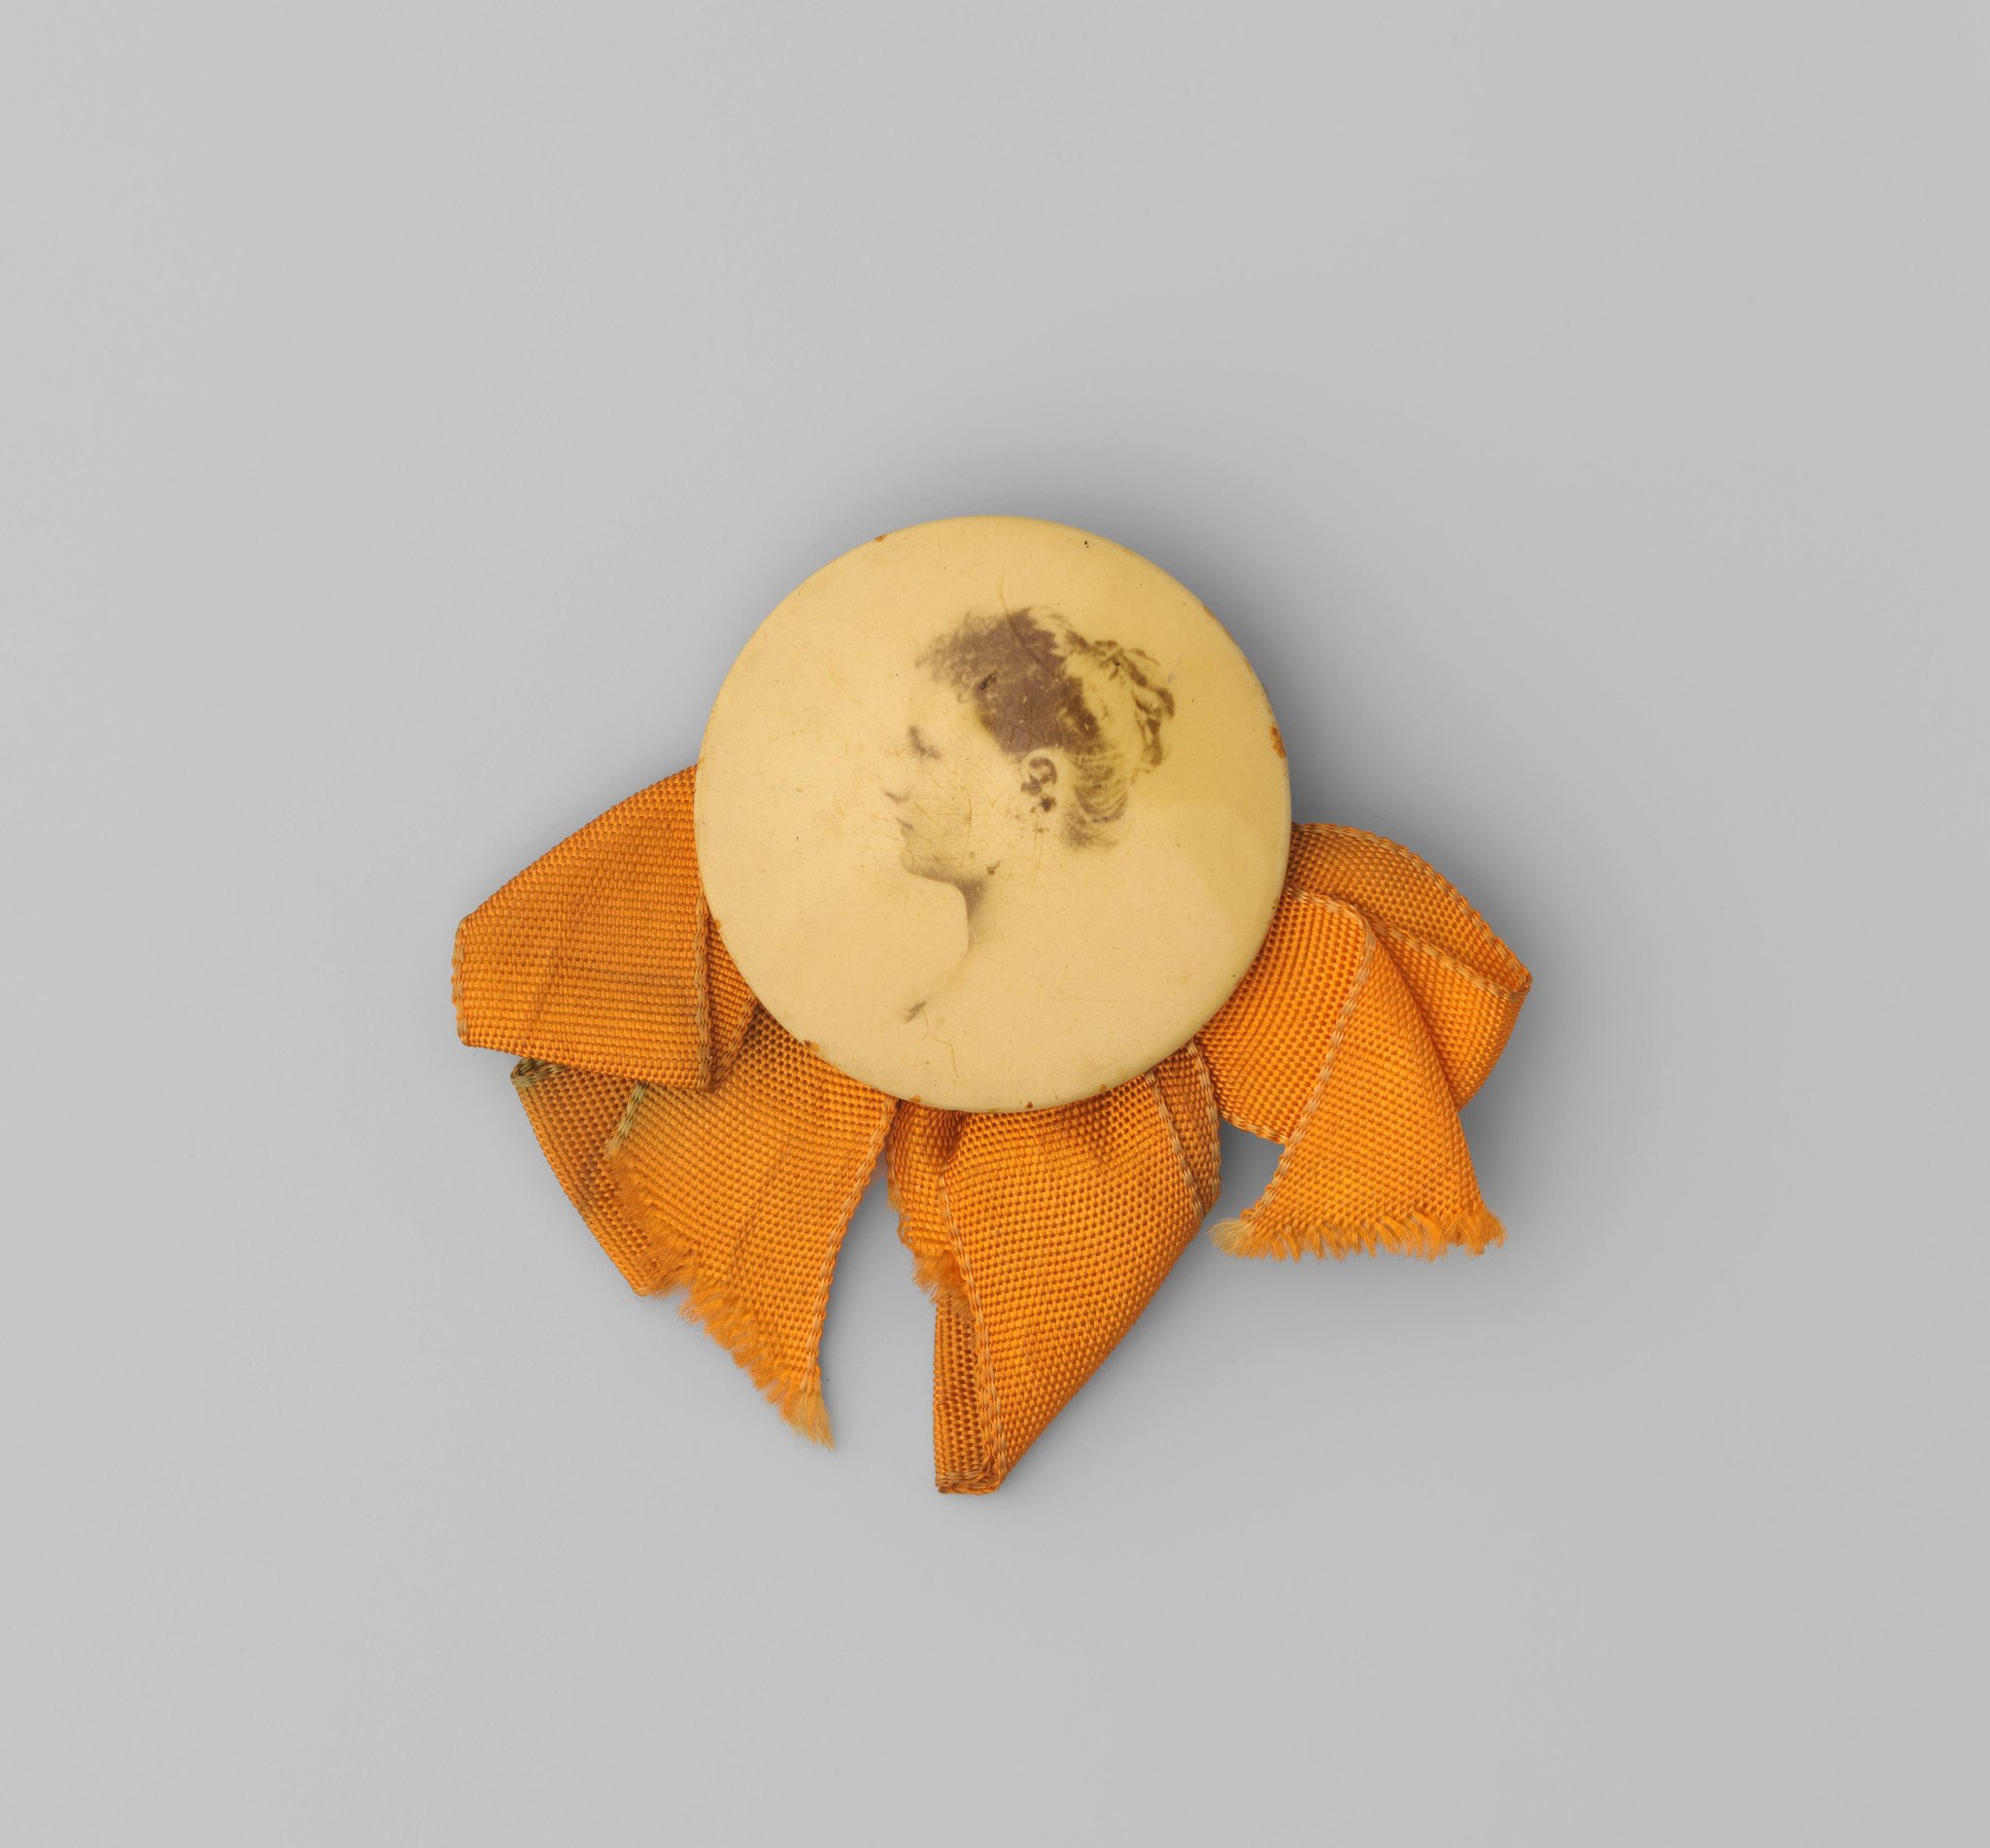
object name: fotobutton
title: Portret van koningin Wilhelmina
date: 1898-1900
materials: celluloid, metal, paper, ribbon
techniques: albumen print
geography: the hague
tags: the hague, wilhelmina of the netherlands, historical persons, queen